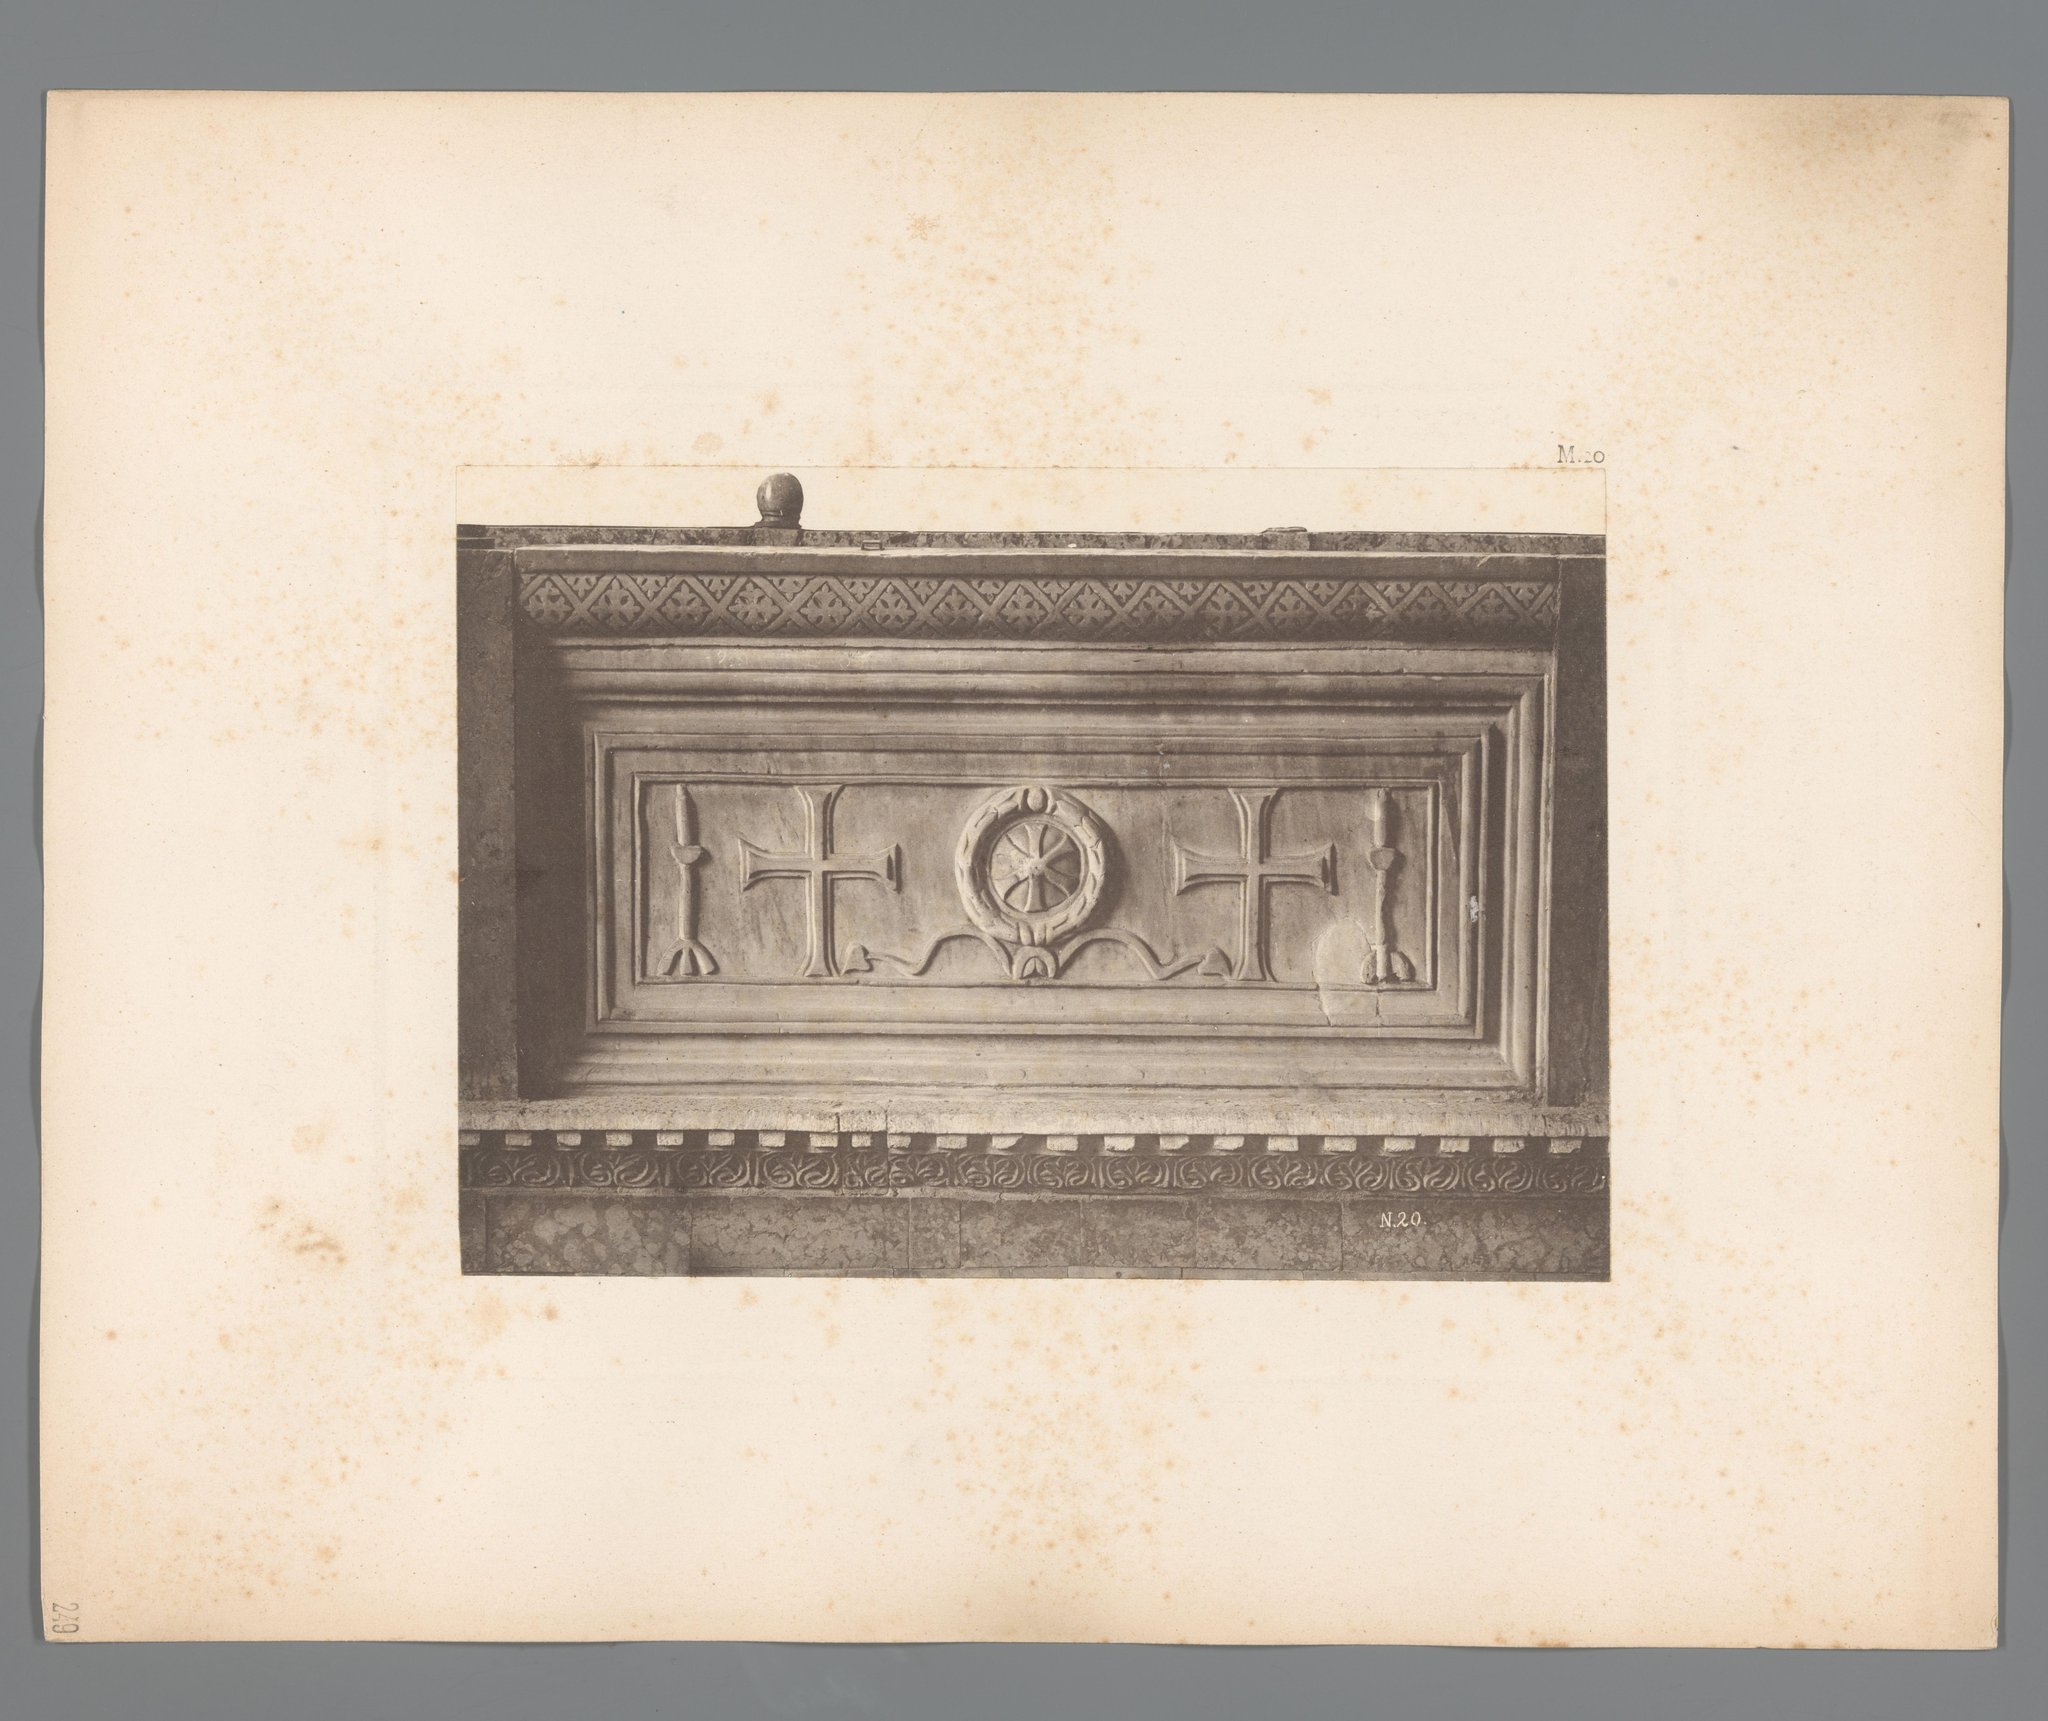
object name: photomechanical print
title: Detail van de San Marco in Venetië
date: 1880-1885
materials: paper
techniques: photograph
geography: venice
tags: piece of sculpture, reproduction of a piece of sculpture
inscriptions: number: ‘249’, number: ‘M.20.’, number: ‘M.20’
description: Deze prent maakt deel uit van een omslag met 58 prenten op 50 bladen.